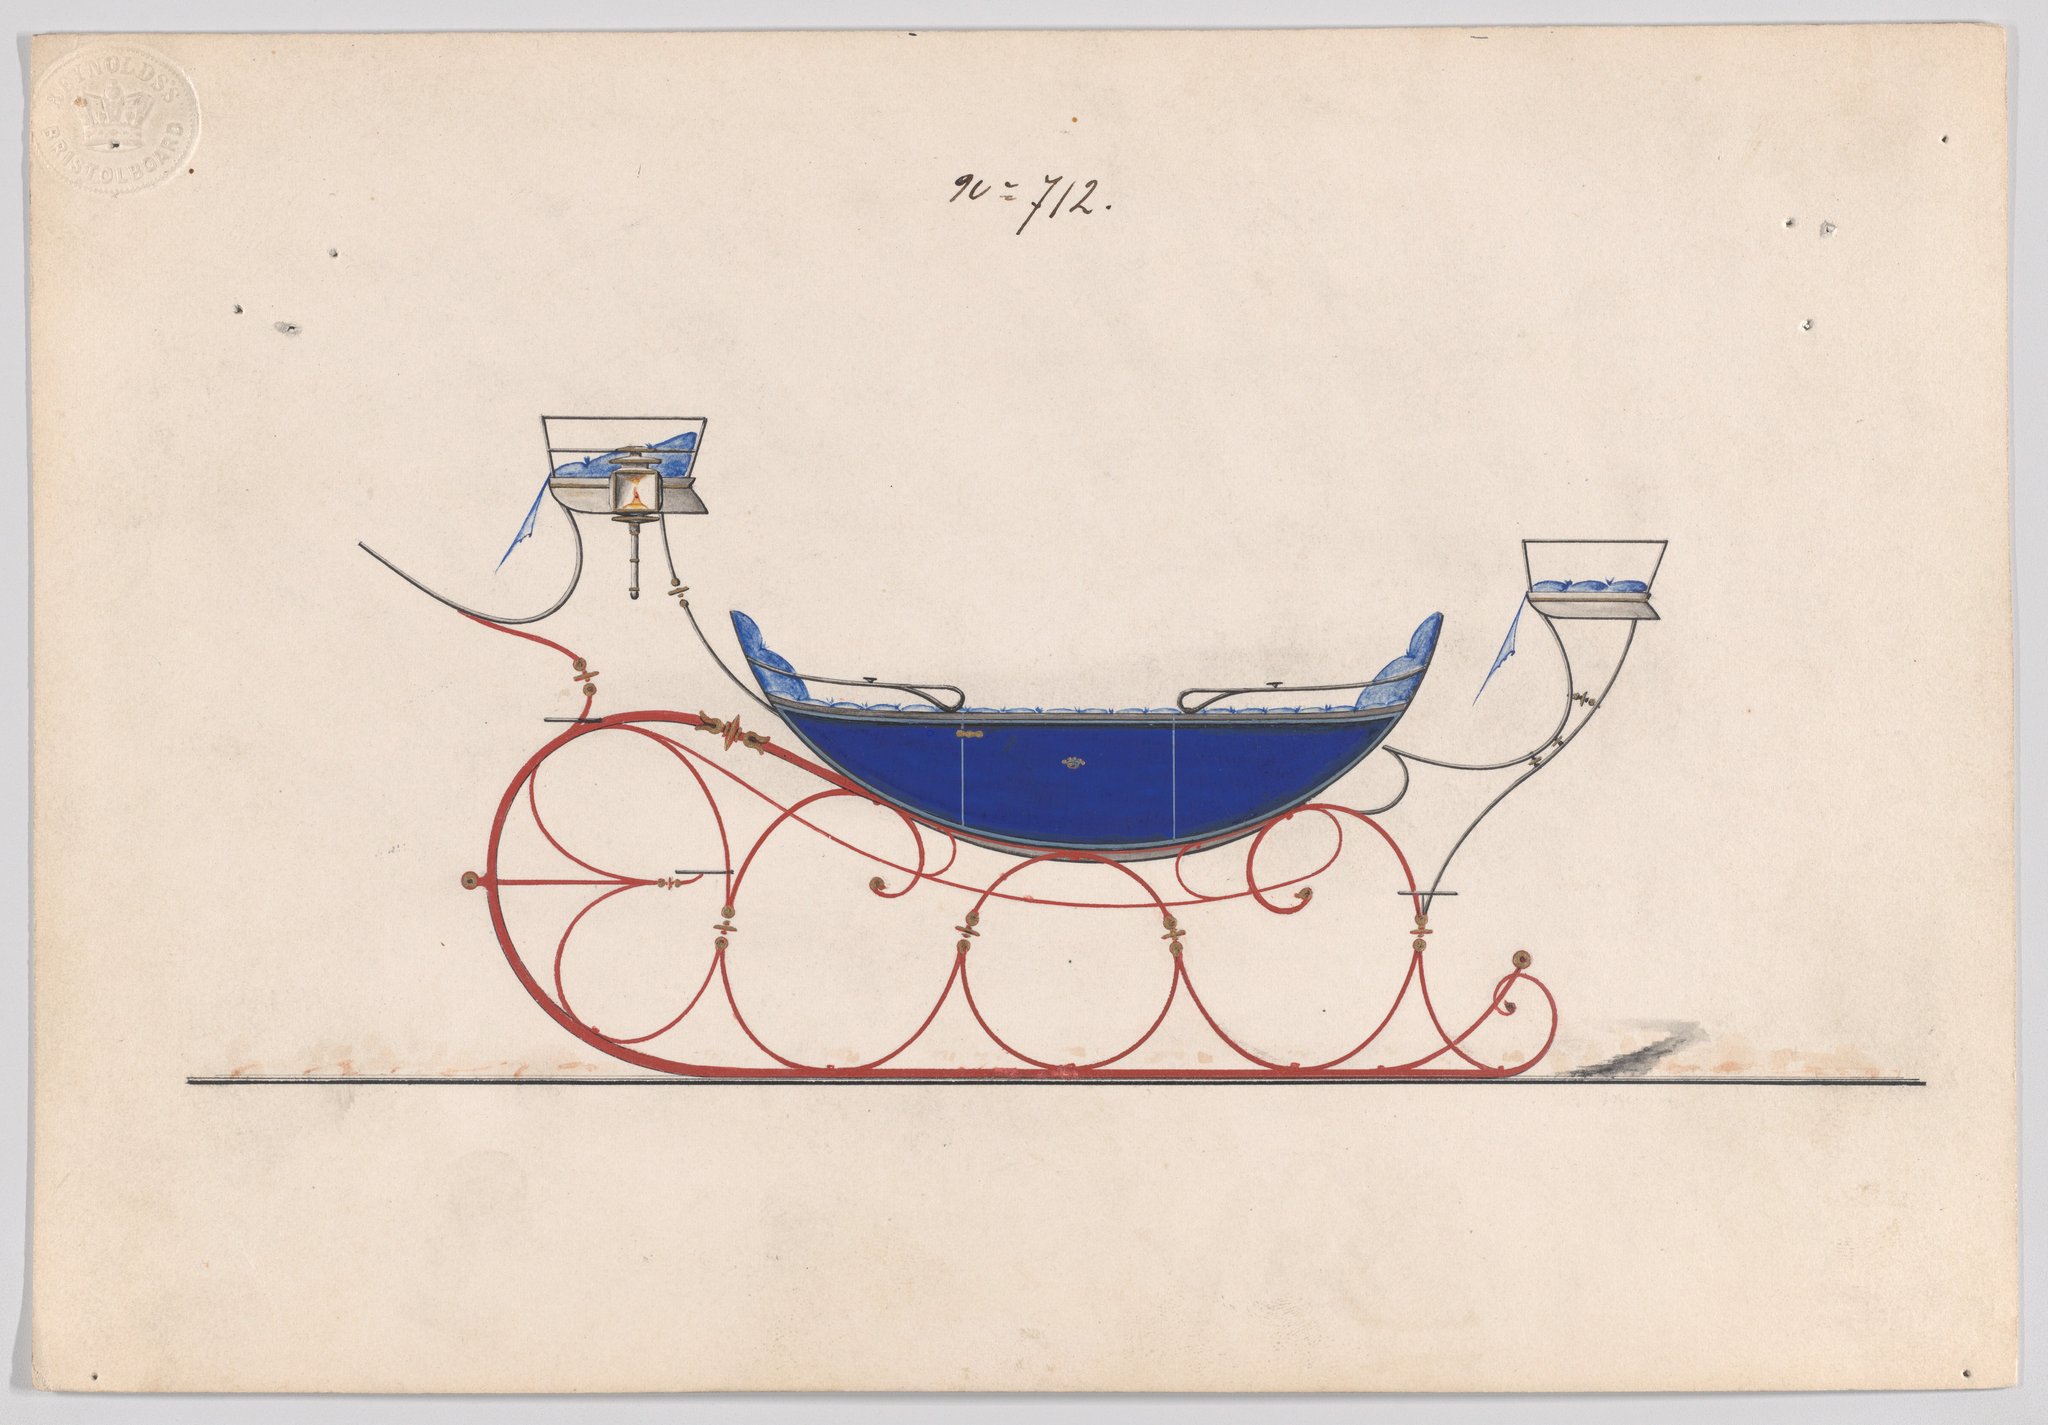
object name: drawing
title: Vis-a-Vis Sleigh #712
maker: brewster & co.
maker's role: manufacturer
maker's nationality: american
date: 1880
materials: gold, gouache, ink, watercolor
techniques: pen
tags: carriages